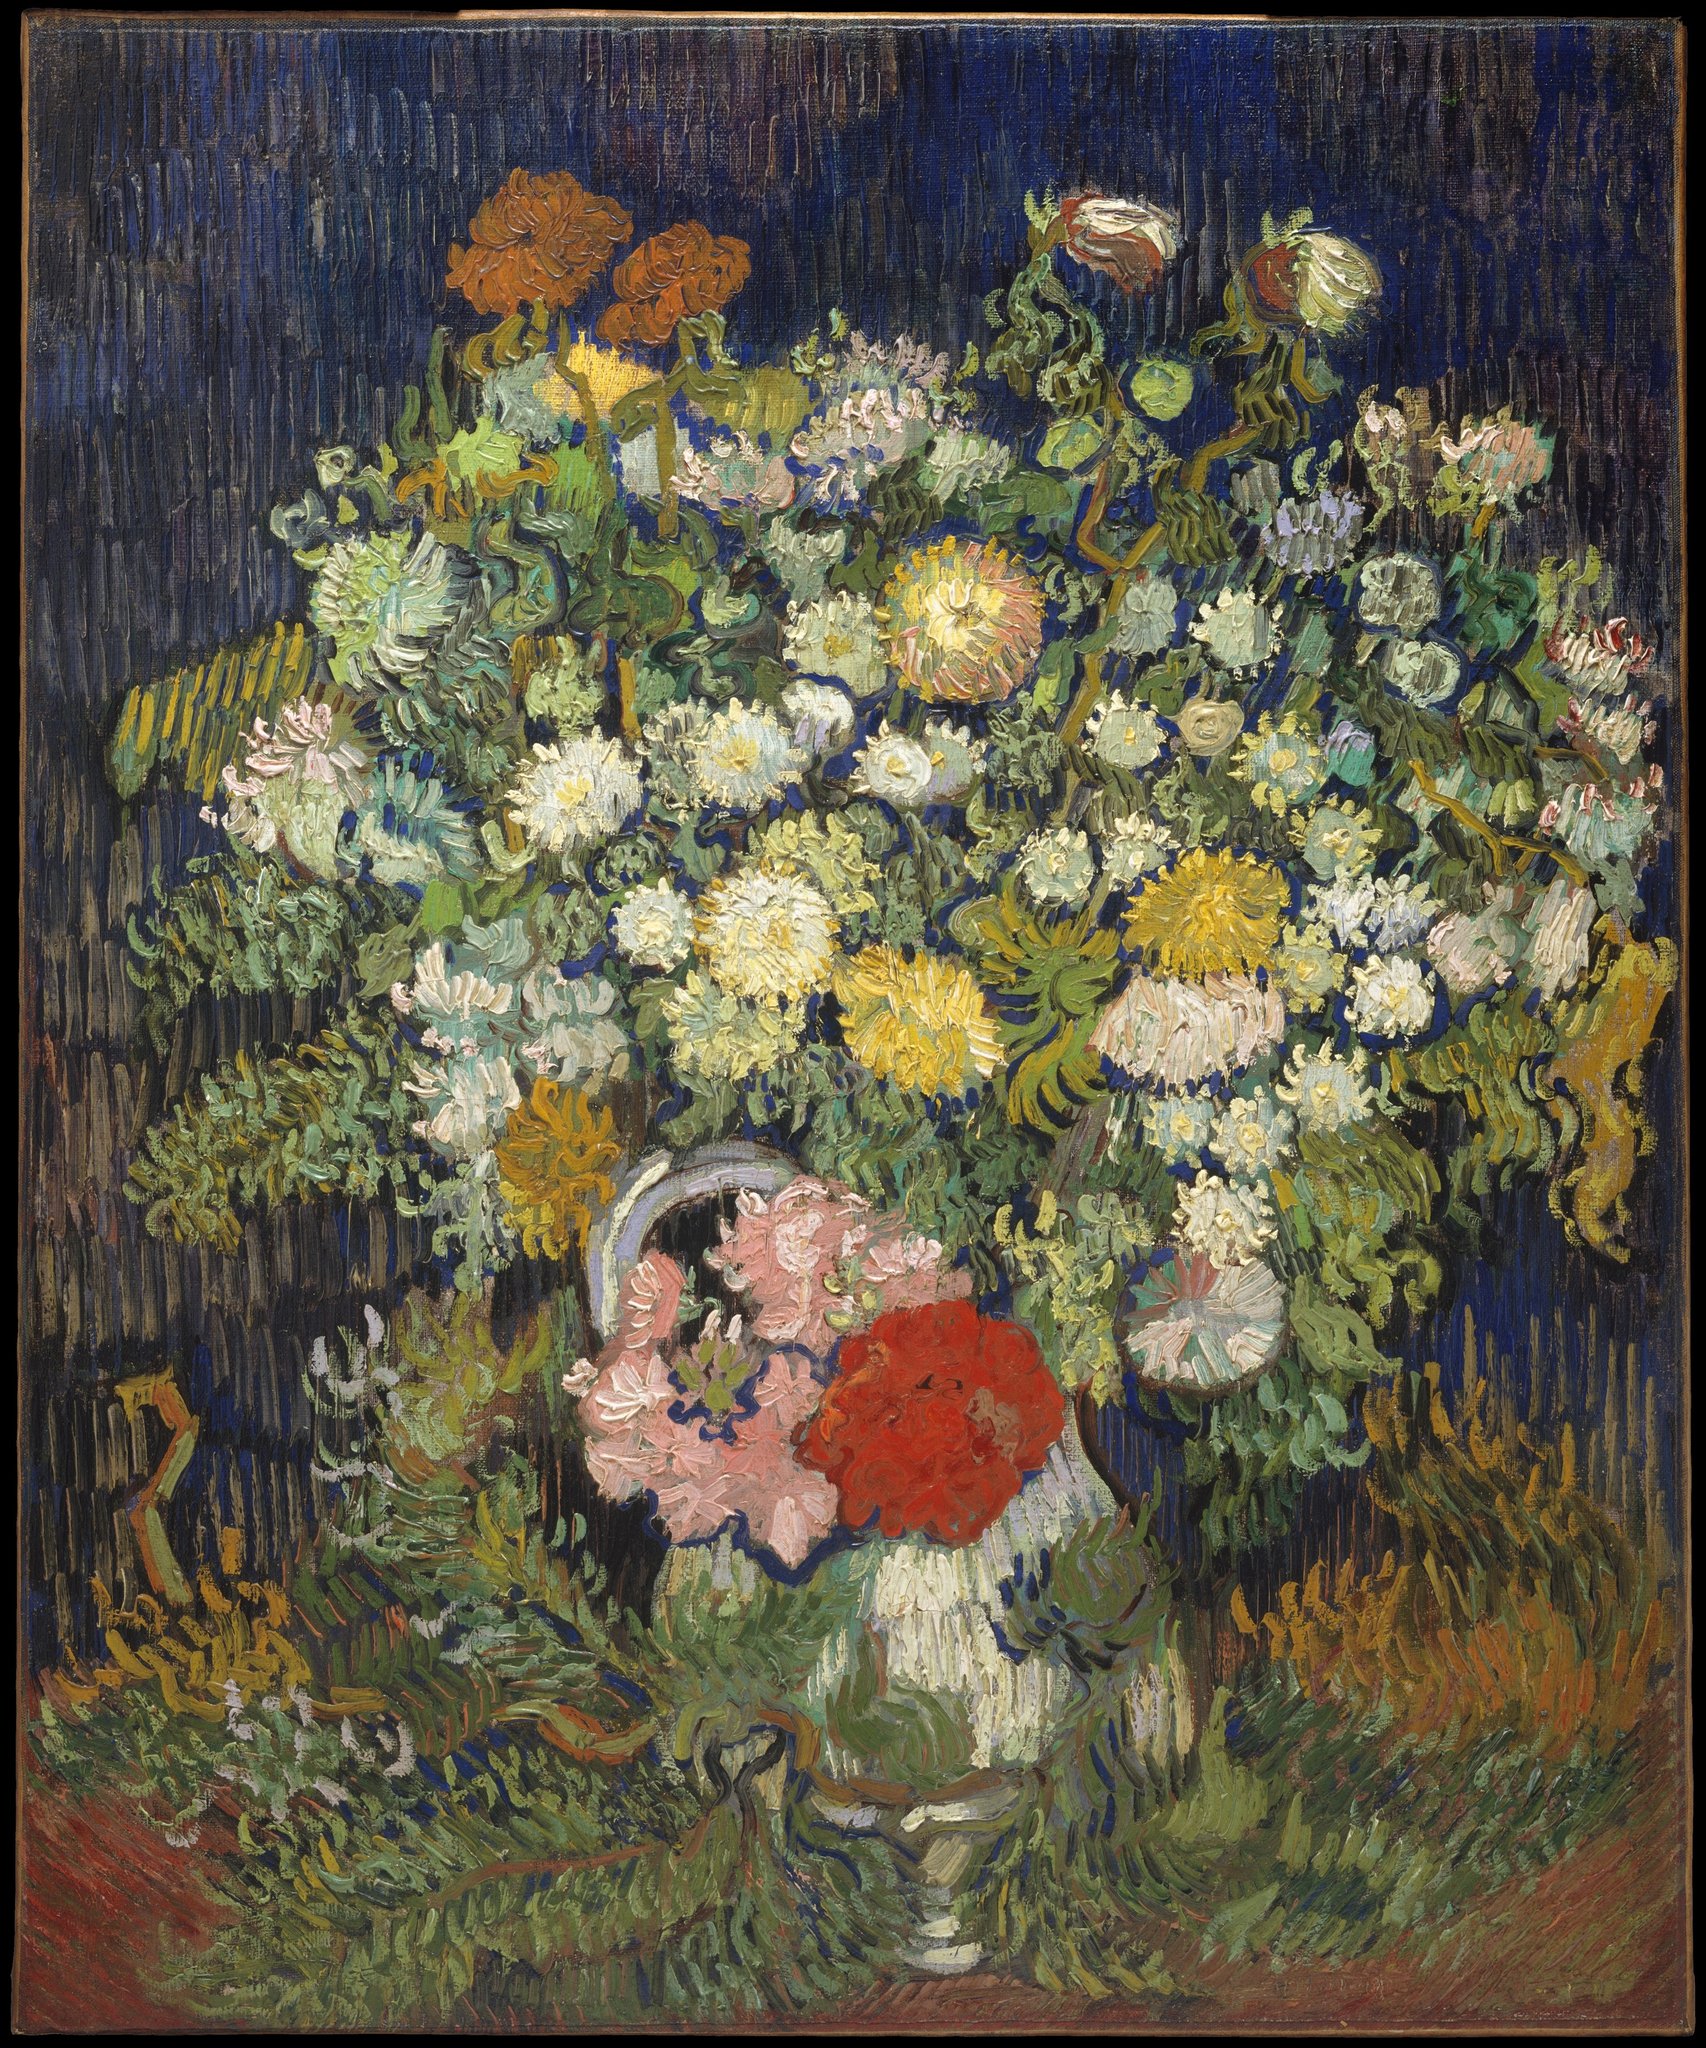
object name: painting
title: Bouquet of Flowers in a Vase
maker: vincent van gogh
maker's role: artist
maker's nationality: dutch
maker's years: 1853-1890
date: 1890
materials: canvas, oil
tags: flowers,still life